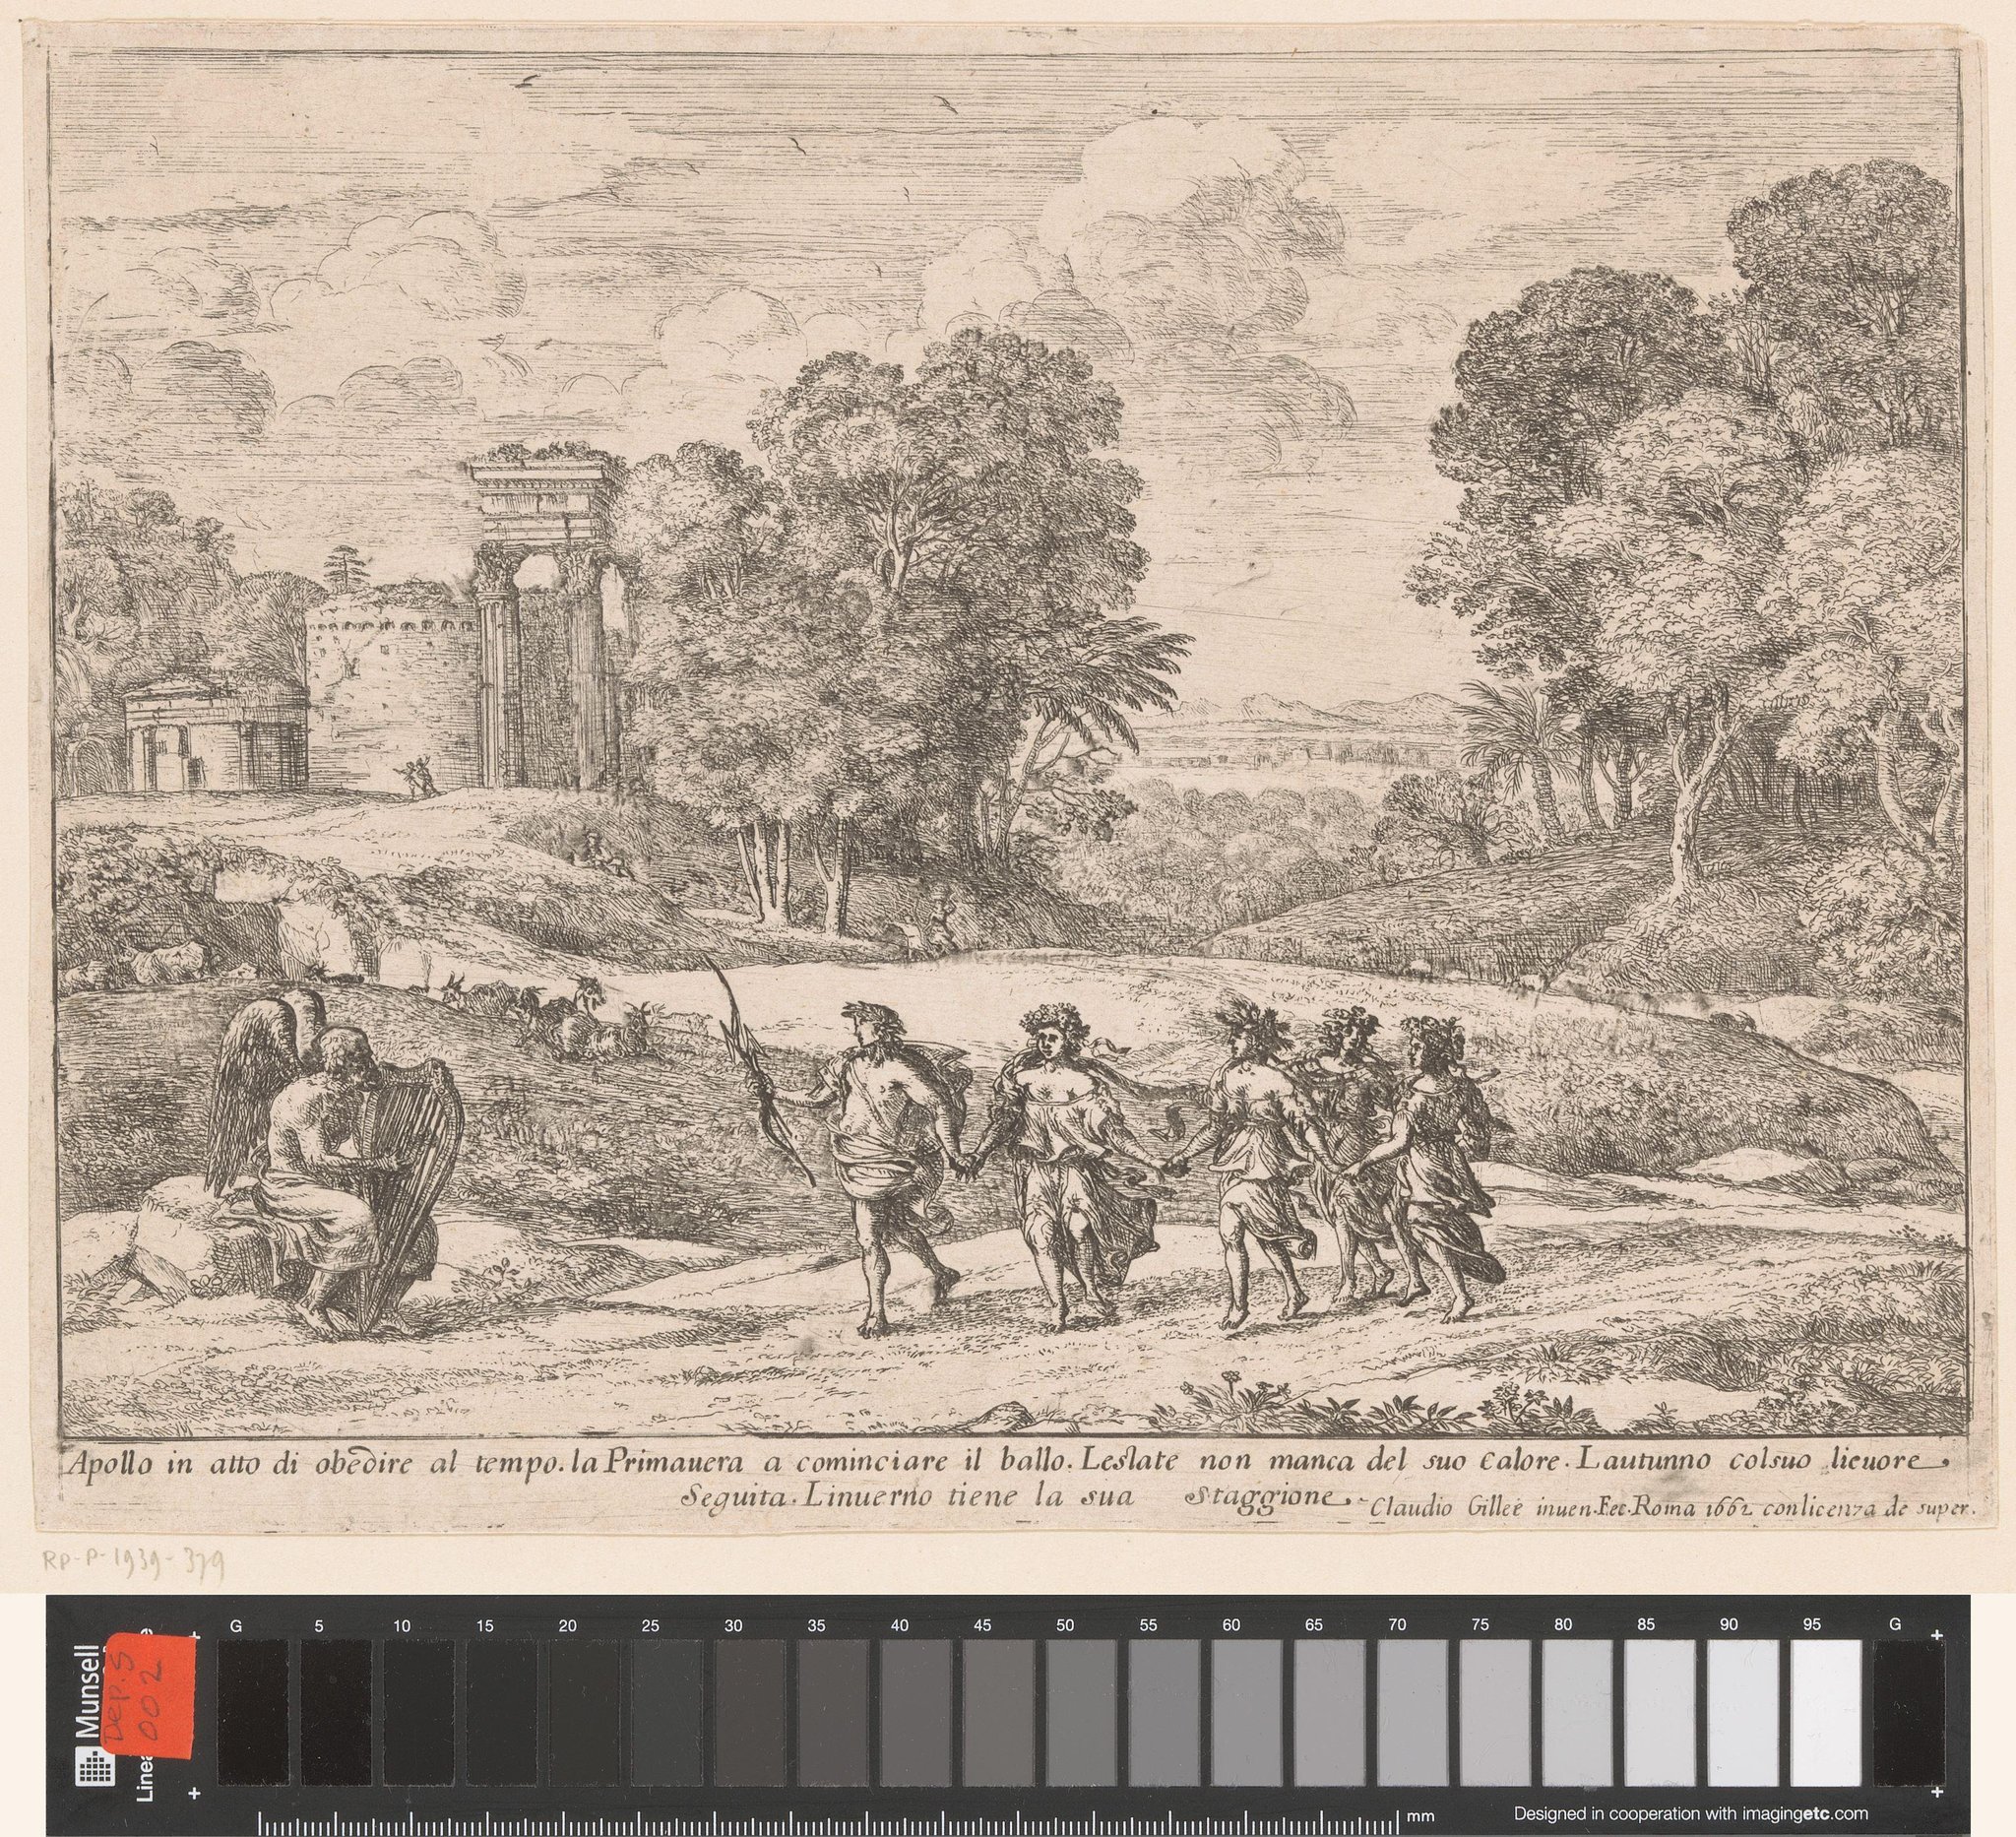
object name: print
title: Tijd, Apollo en de vier seizoenen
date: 1662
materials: paper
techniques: etching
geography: rome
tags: seasons of the year (esp. personifications); 'stagione', 'le quattro stagione dell'anno' (ripa), (story of) apollo (phoebus), father time, man with wings and scythe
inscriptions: collector's mark: Lugt 2760, collector's mark: Lugt 2166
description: De Tijd zittend op een steen en spelend op zijn harp. Apollo hand in hand met vier vrouwen, de personificaties van de vier seizoenen, lopend door een landschap met ruïnes. Onder de voorstelling een tweeregelige tekst in het Italiaans.